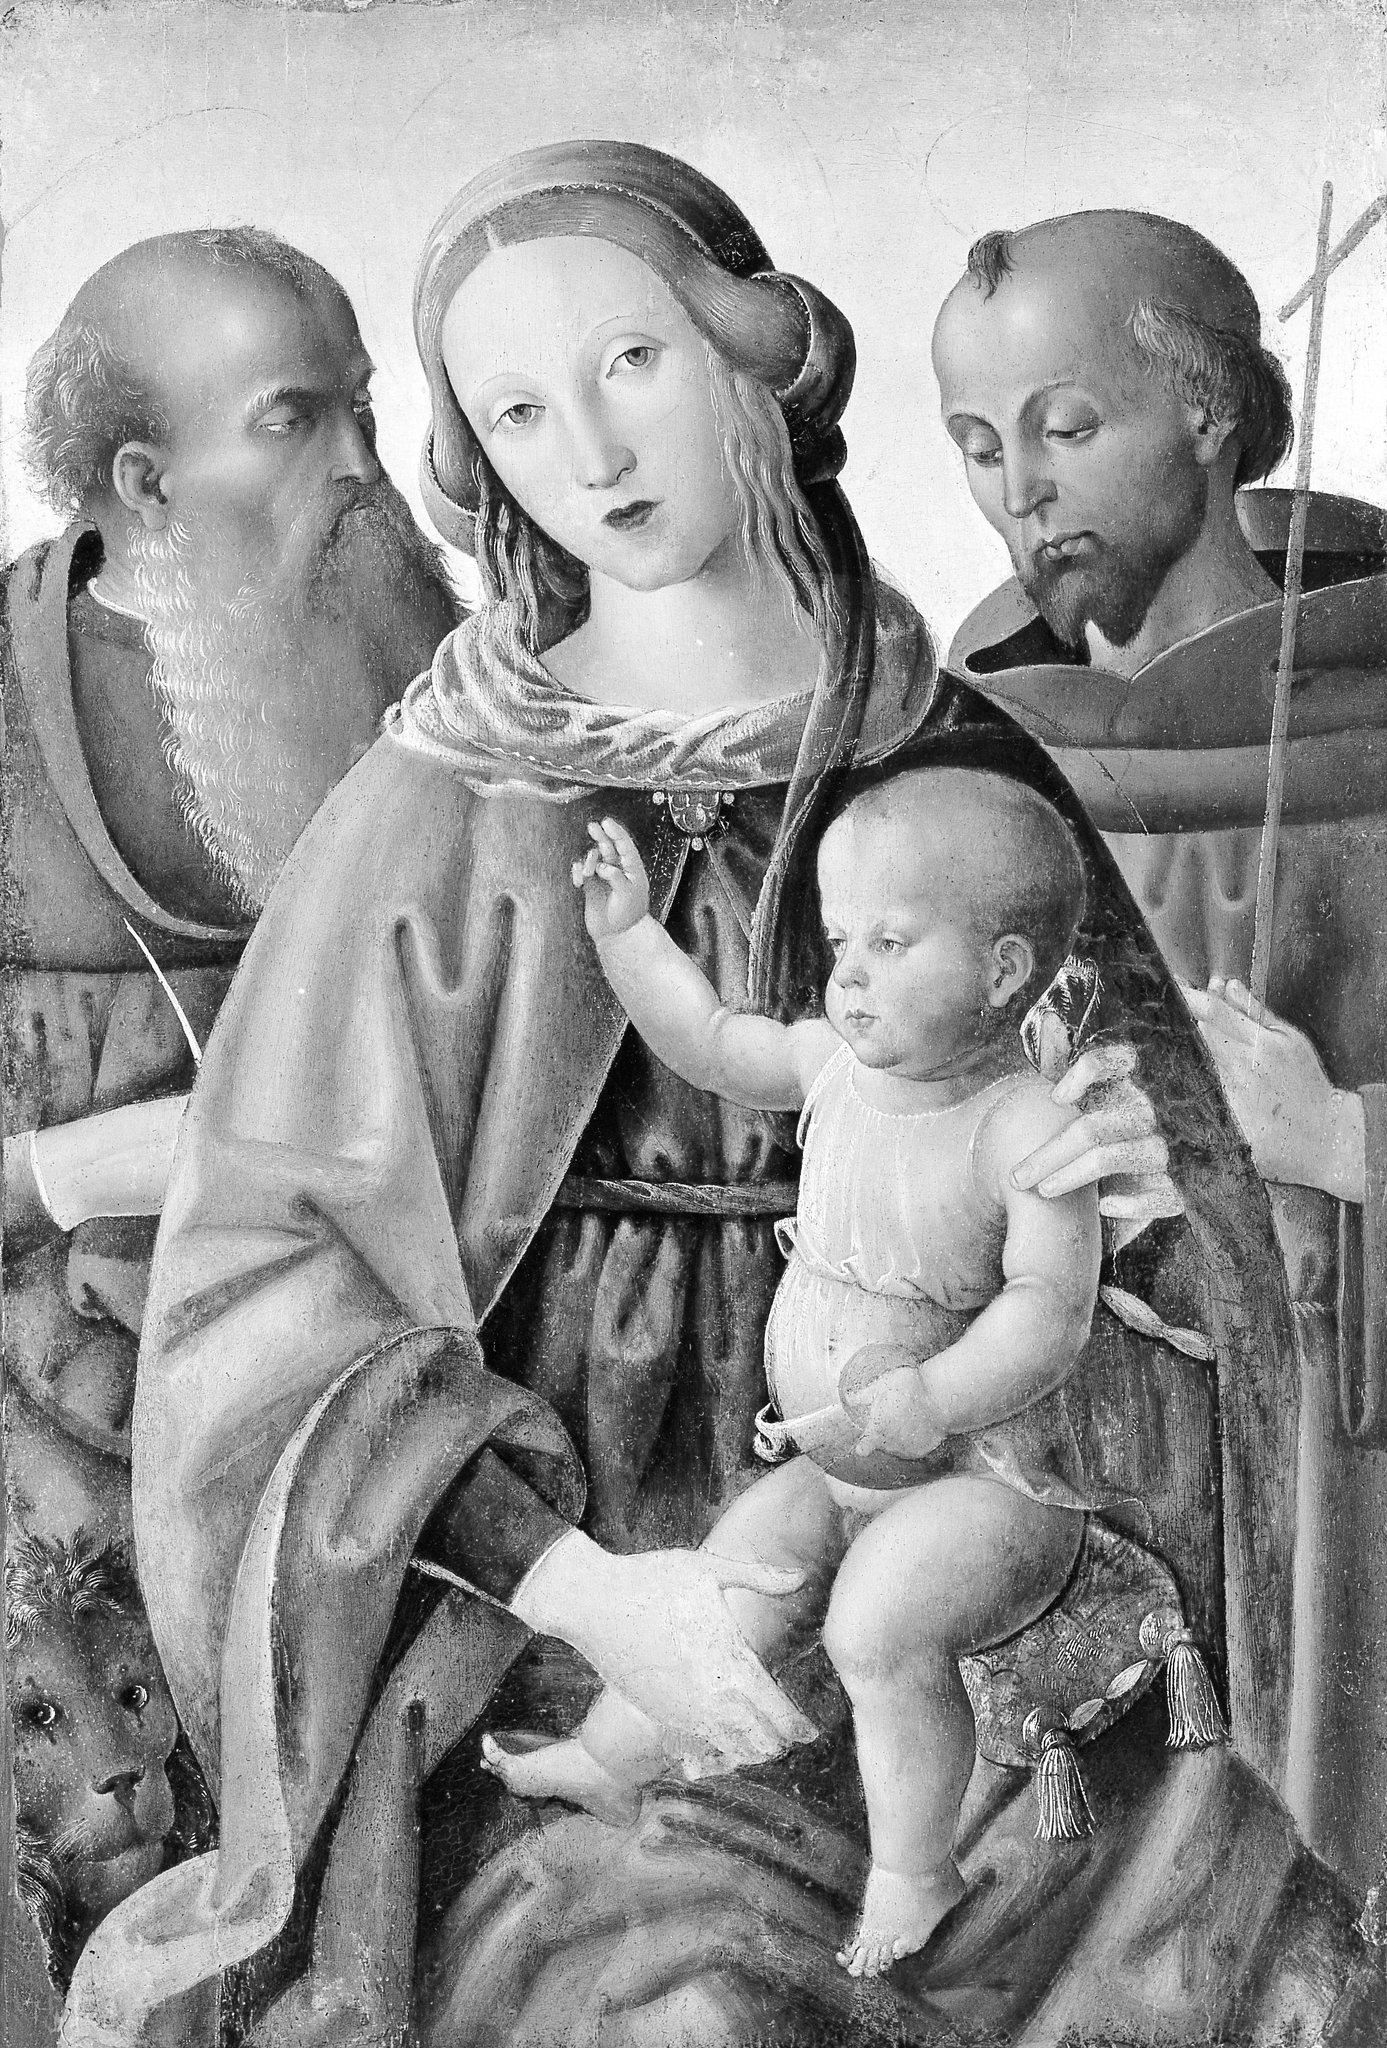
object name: painting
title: Madonna and Child with Saints Jerome and Francis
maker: italian (umbrian) painter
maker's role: artist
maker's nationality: italian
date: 1495-1505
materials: paint, wood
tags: lions,madonna and child,saint francis,saint jerome